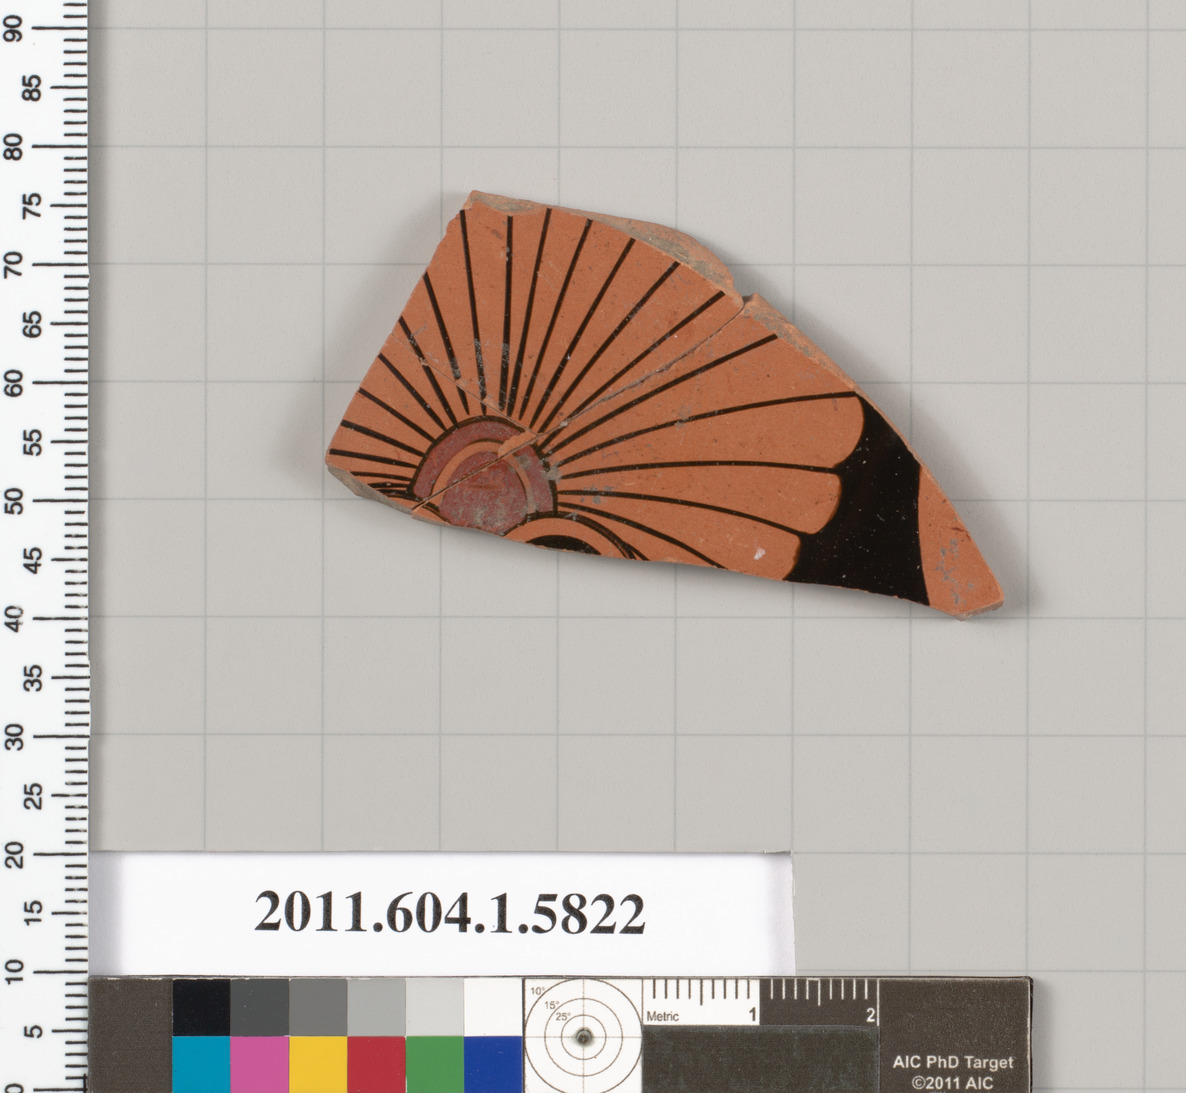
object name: kylix fragment, eye cup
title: Terracotta fragment of a kylix: eye-cup (drinking cup)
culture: greek, attic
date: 520-510 BCE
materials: terracotta